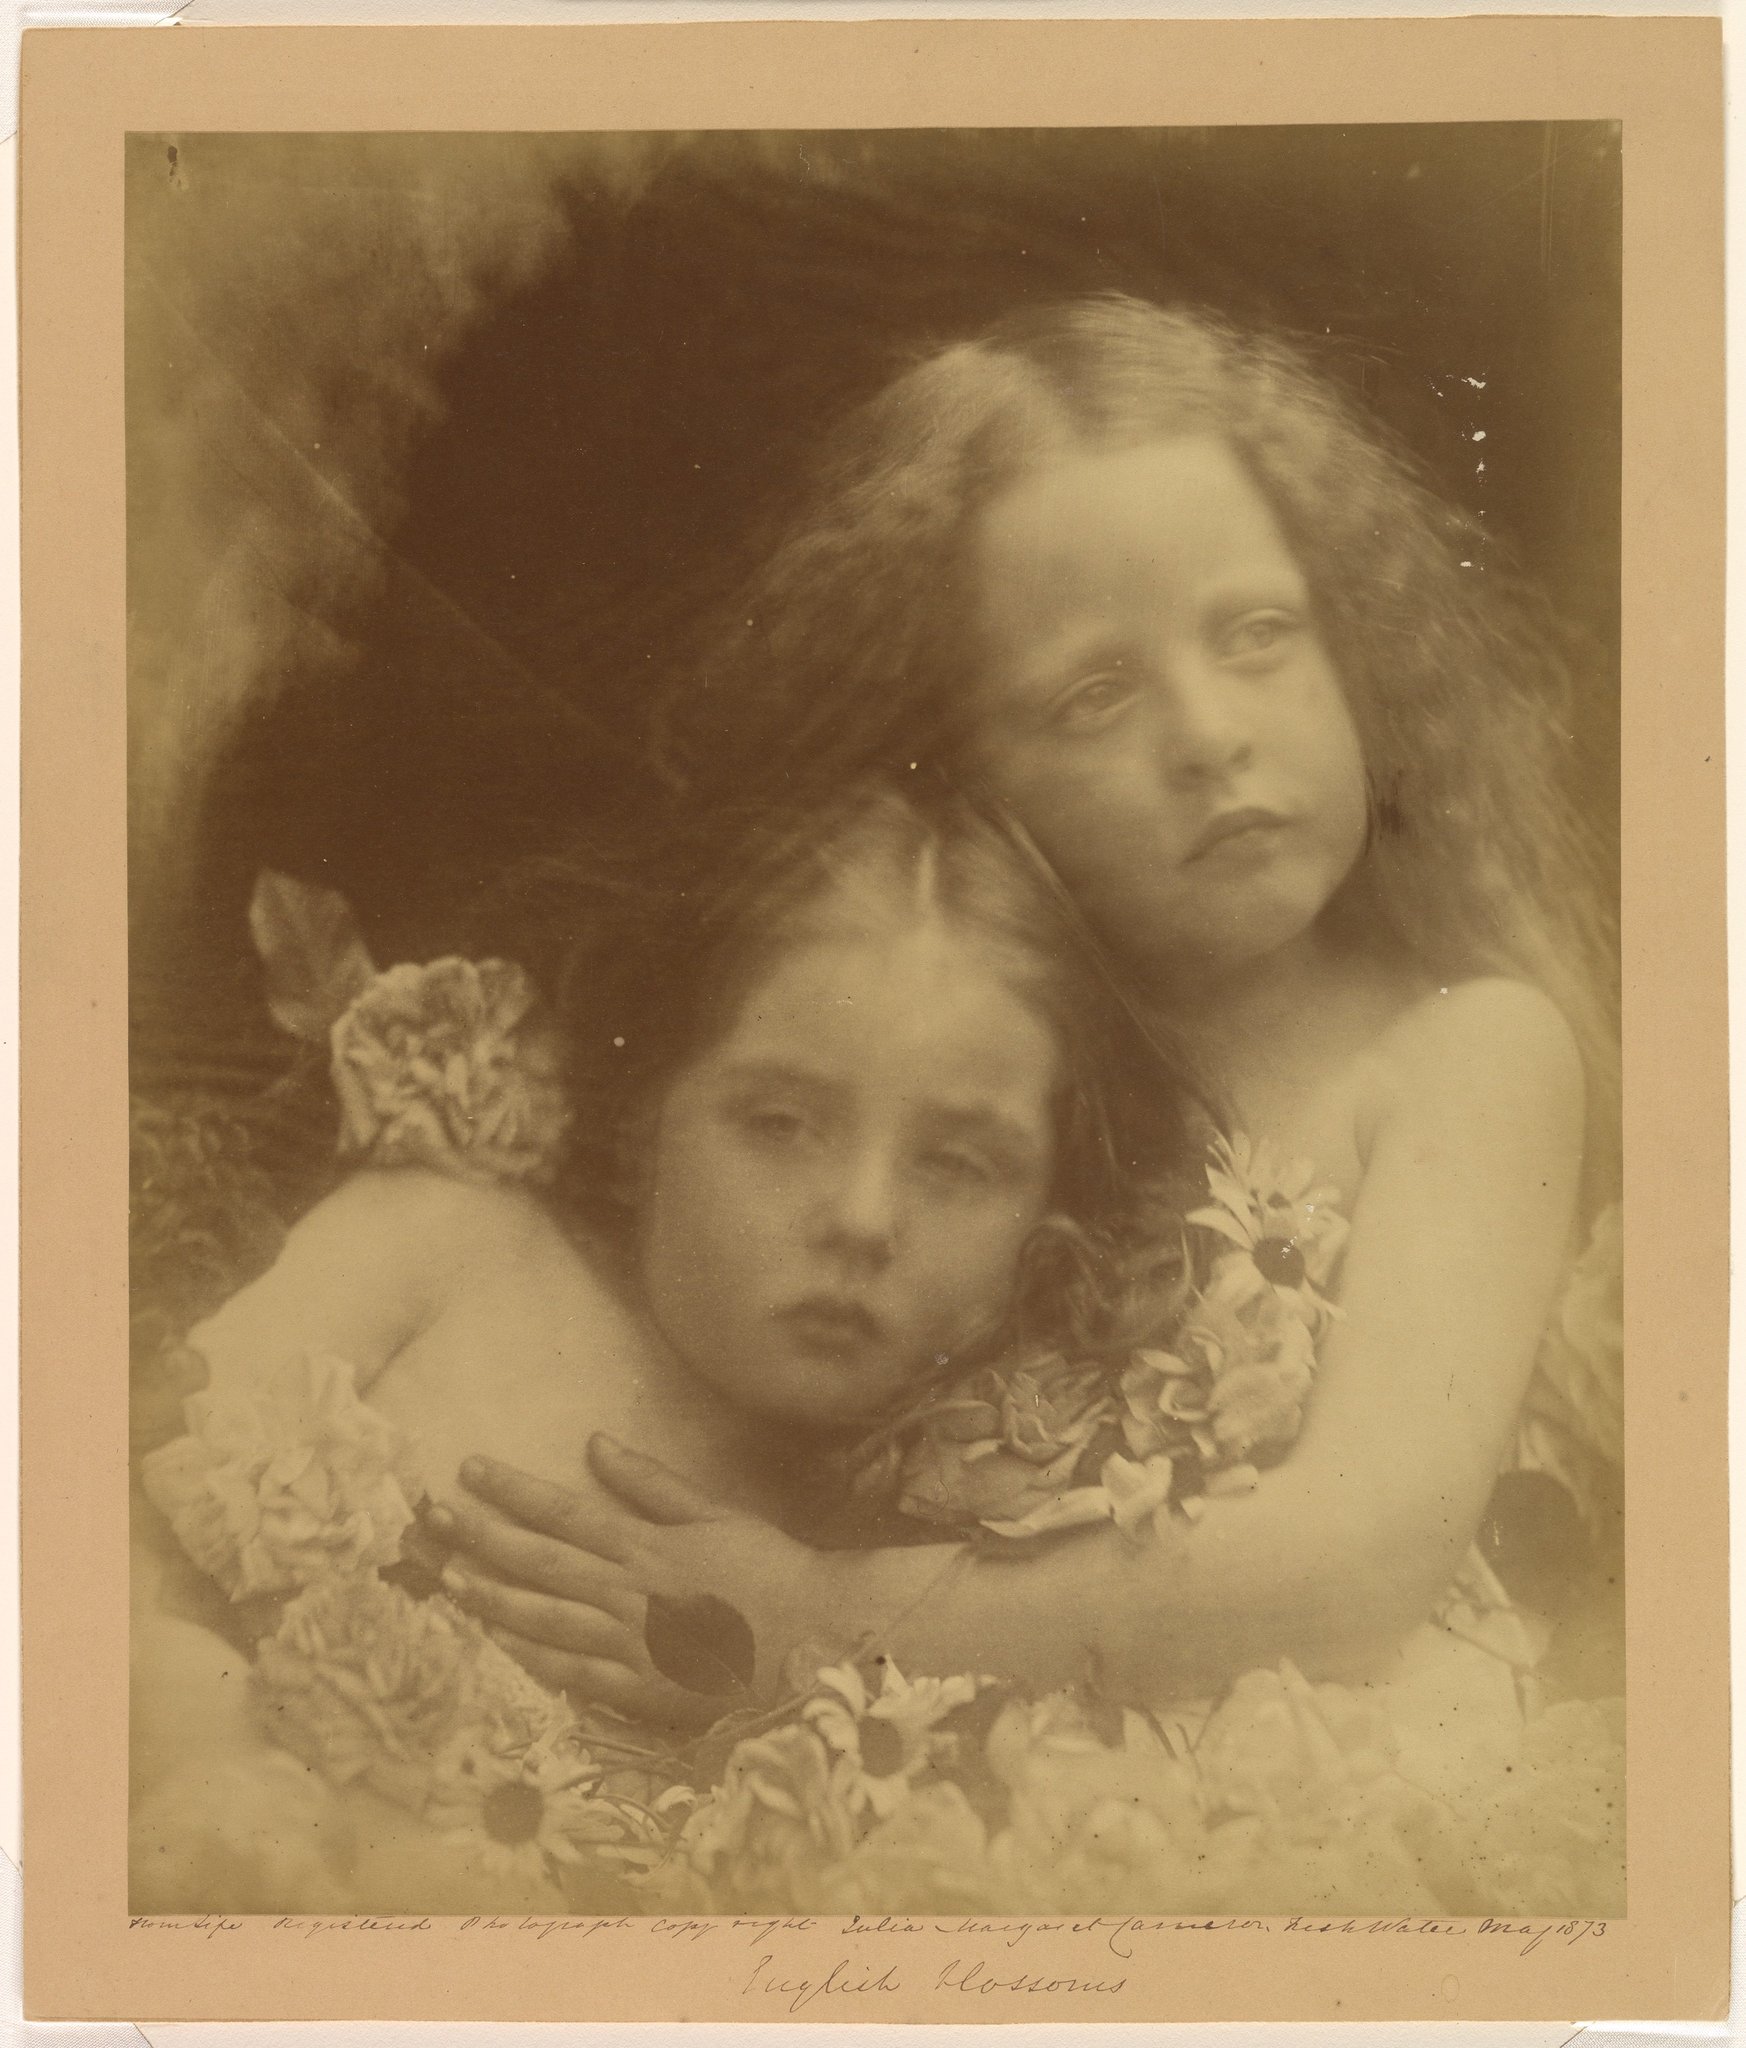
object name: photograph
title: English Blossoms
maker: julia margaret cameron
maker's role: artist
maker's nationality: british, born india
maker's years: 1815-1879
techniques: albumen silver print, glass negative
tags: girls,portraits